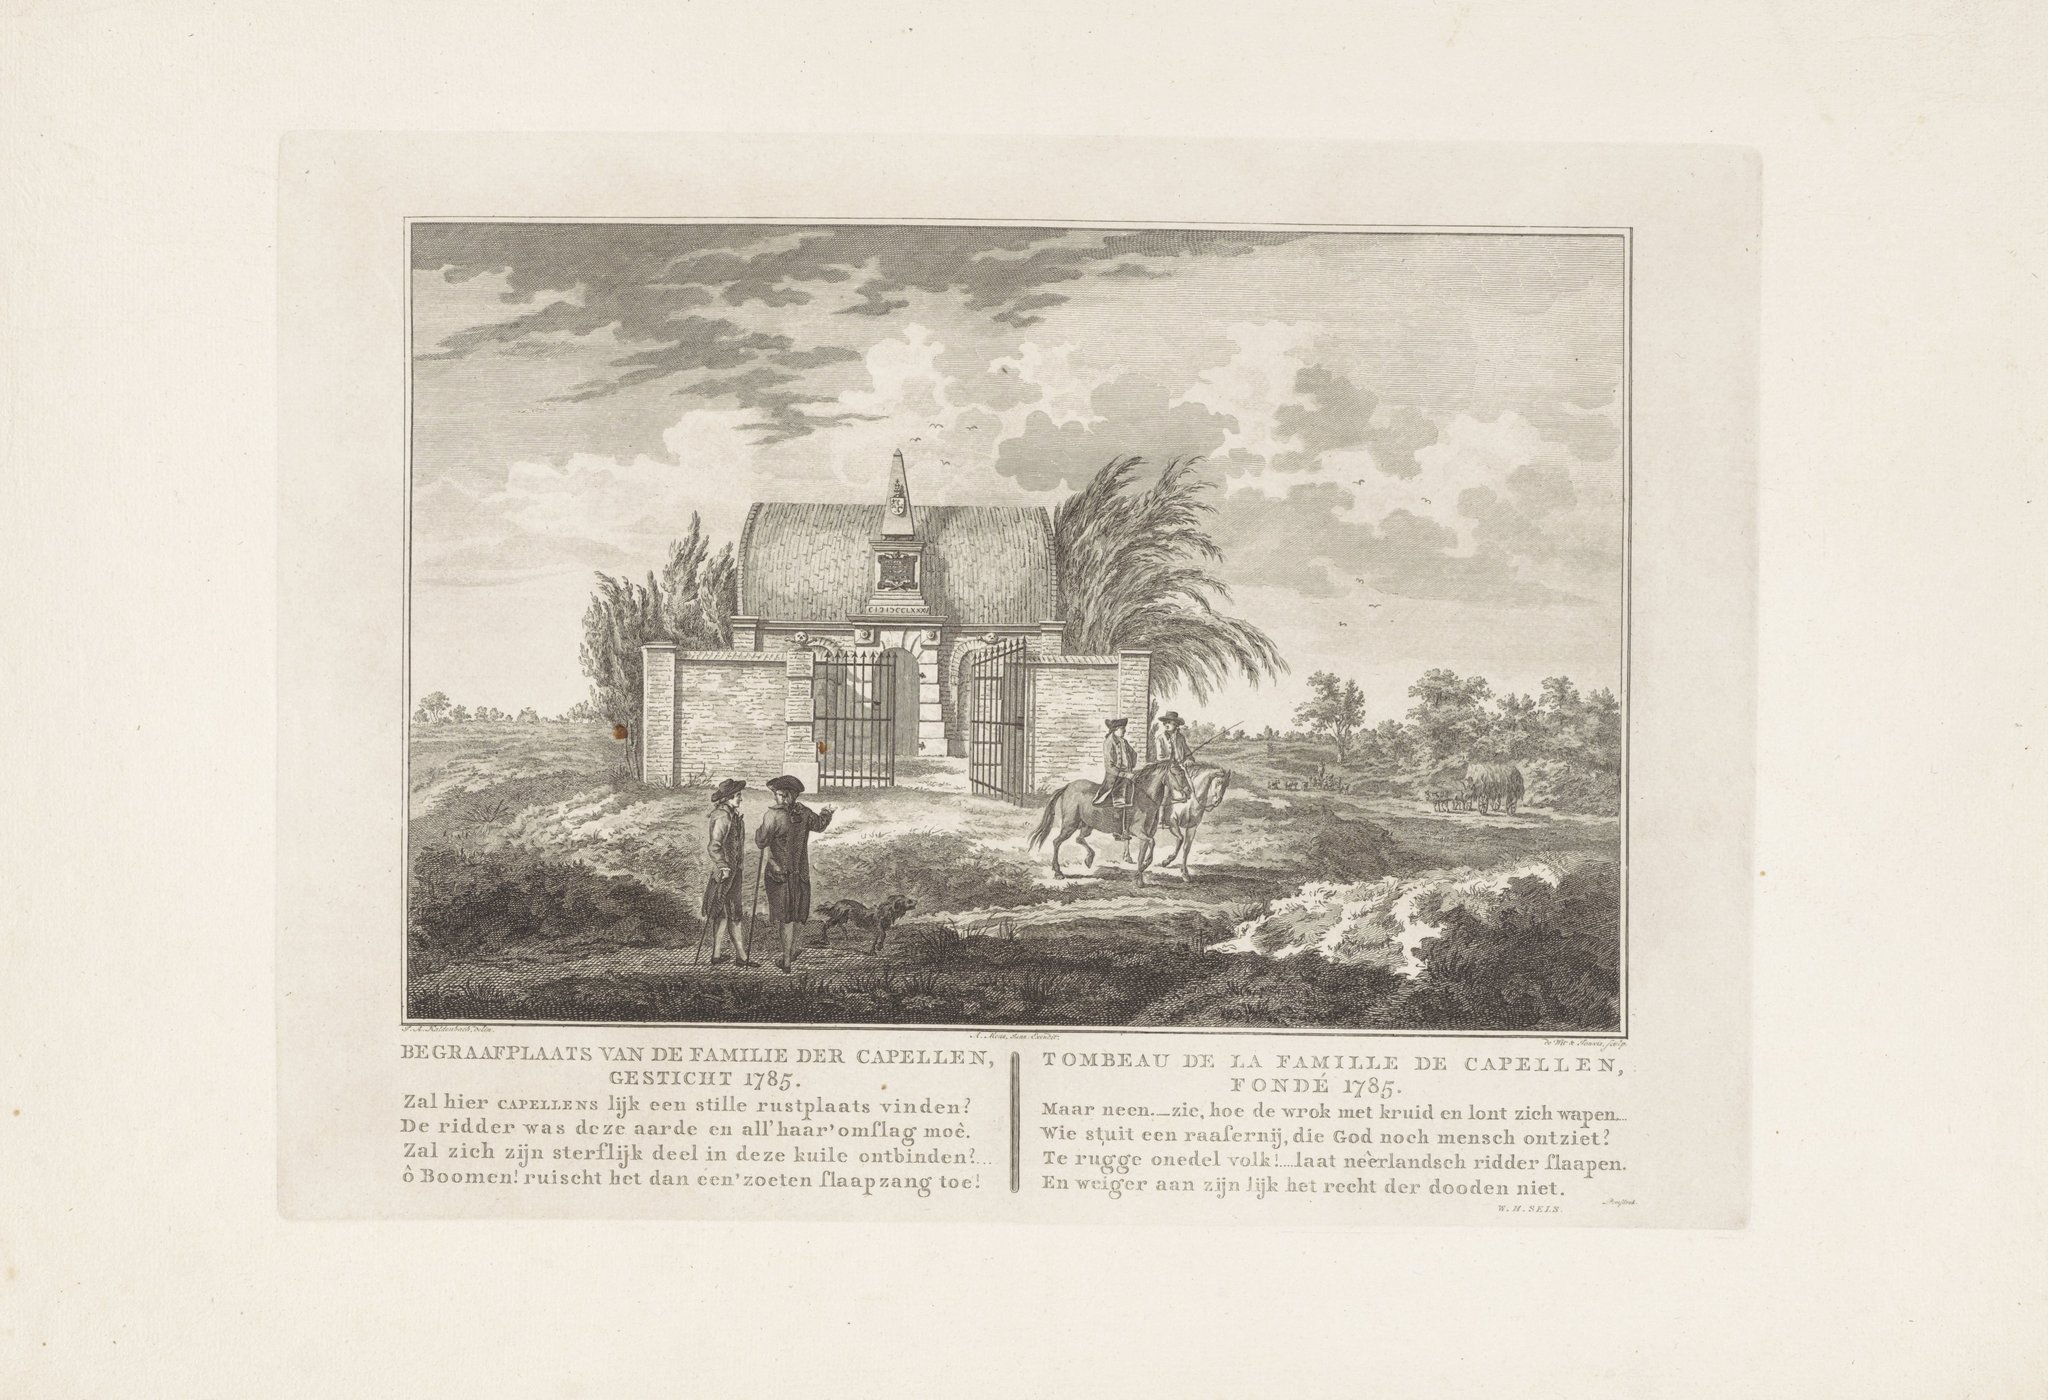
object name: print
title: Landschap met de begraafplaats van familie Van der Capellen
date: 1788-1790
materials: paper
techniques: etching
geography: amsterdam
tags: riding a horse, ass, or mule; rider, horseman, landscape with other man-made constructions not mentioned above, e.g.: graveyards, playgrounds, etc., hay-wagon, dog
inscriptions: collector's mark: Lugt 2233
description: Landschap met de begraafplaats van familie Van der Capellen met op de voorgrond twee wandelaars met een hond en twee ruiters. Op de achtergrond een herder met een kudde en een hooiwagen.